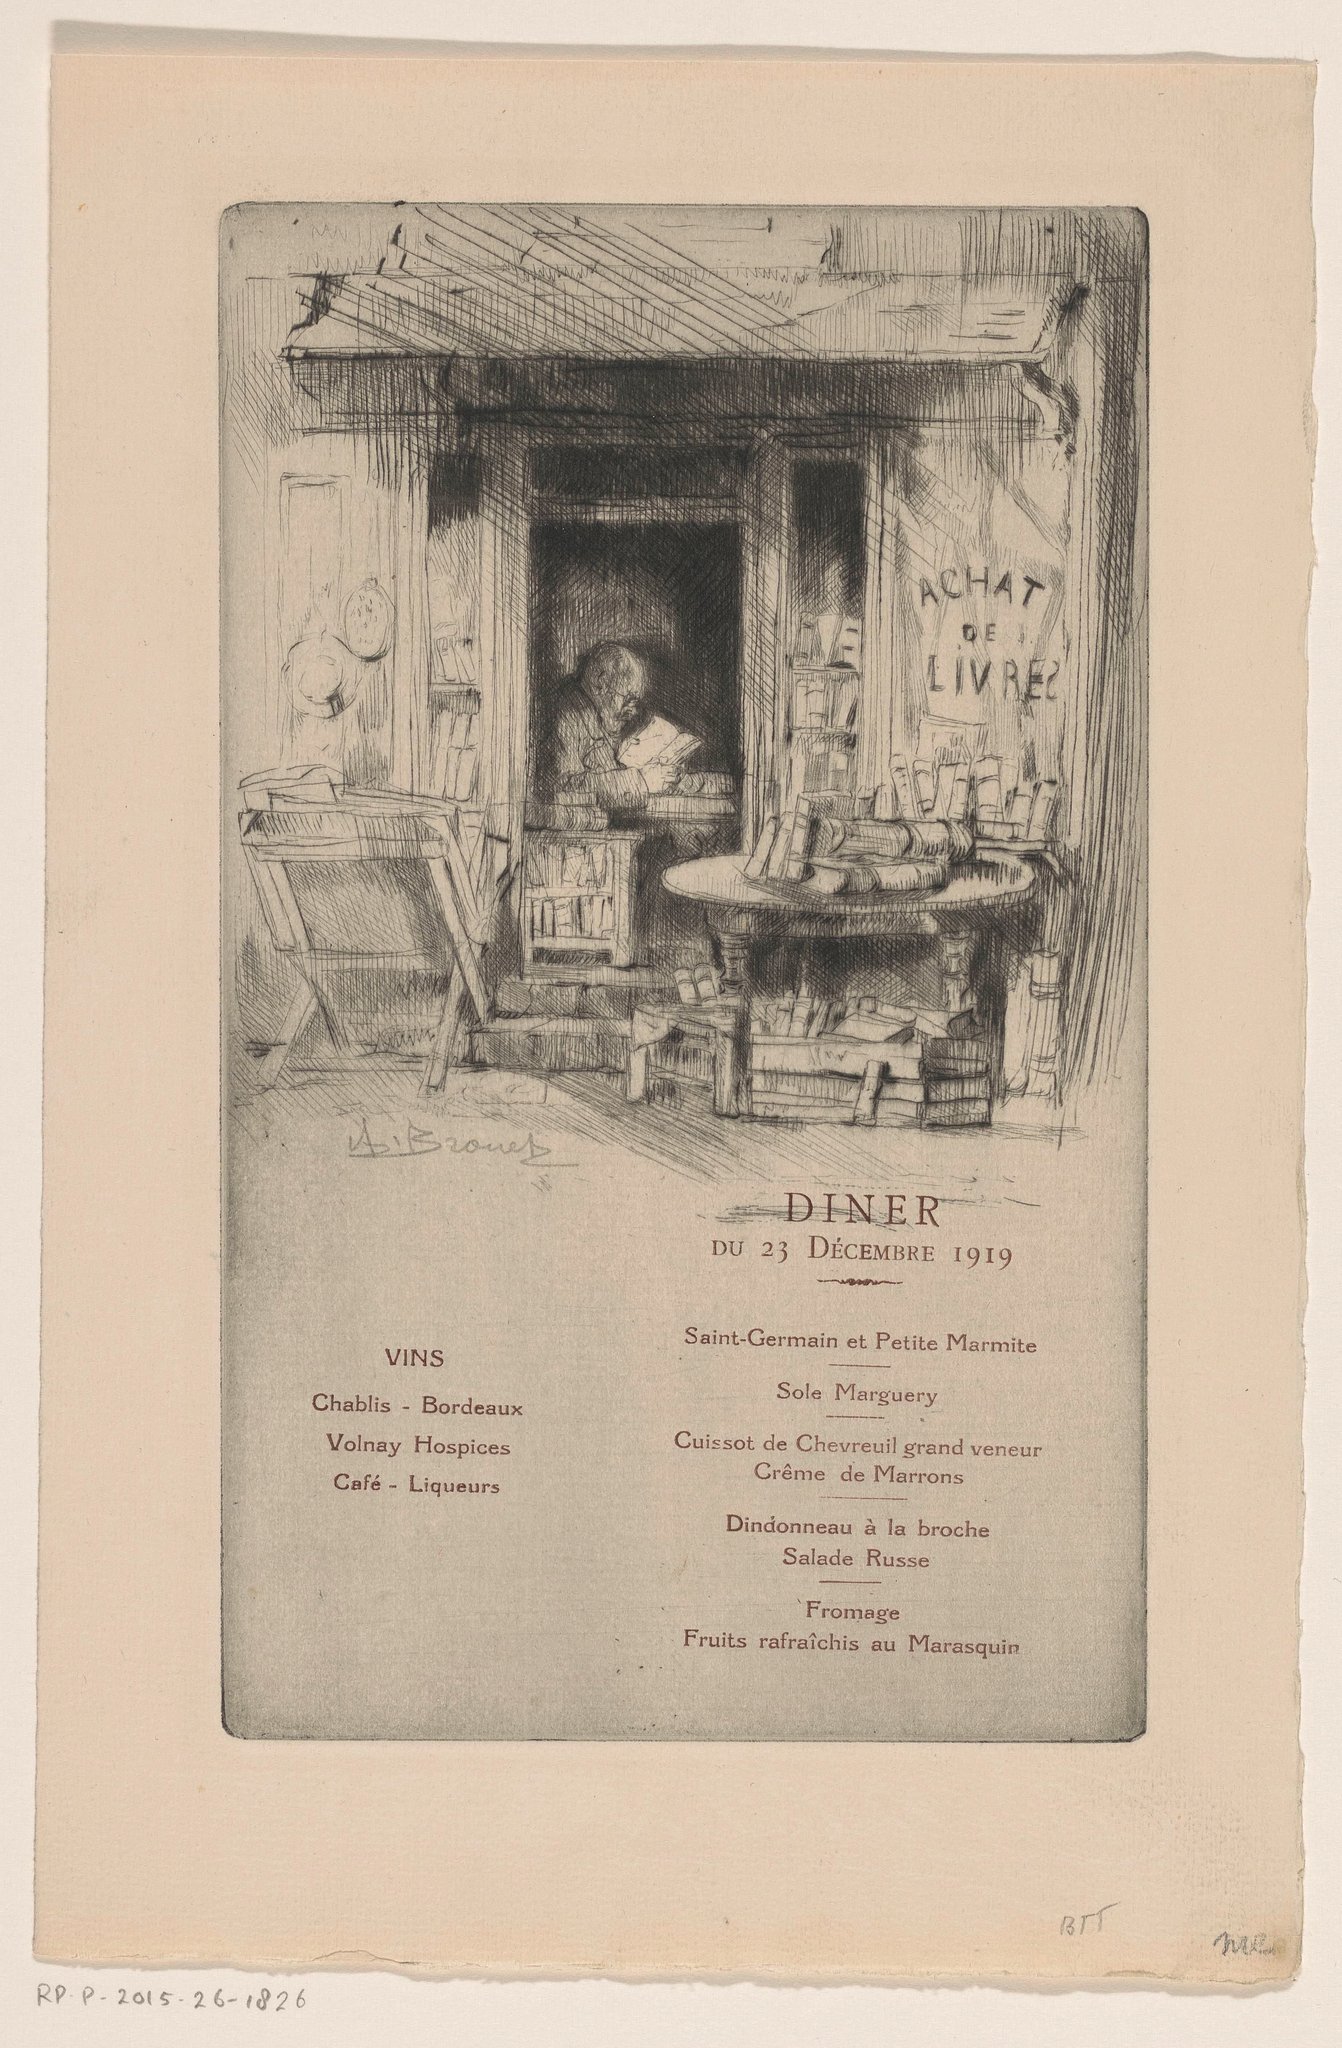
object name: print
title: Menukaart voor Les Cent bibliophiles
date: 1919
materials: paper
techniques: drypoint, intaglio, letterpress printing, roulette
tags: reading, book, book-shop, bookseller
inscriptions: collector's mark: Lugt 4779, watermark: ‘Eug. Delâtre’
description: In de deuropening van zijn winkel zit een boekhandelaar te lezen. Buiten onder een afdak staan een prentstandaard en een tafel vol boeken.